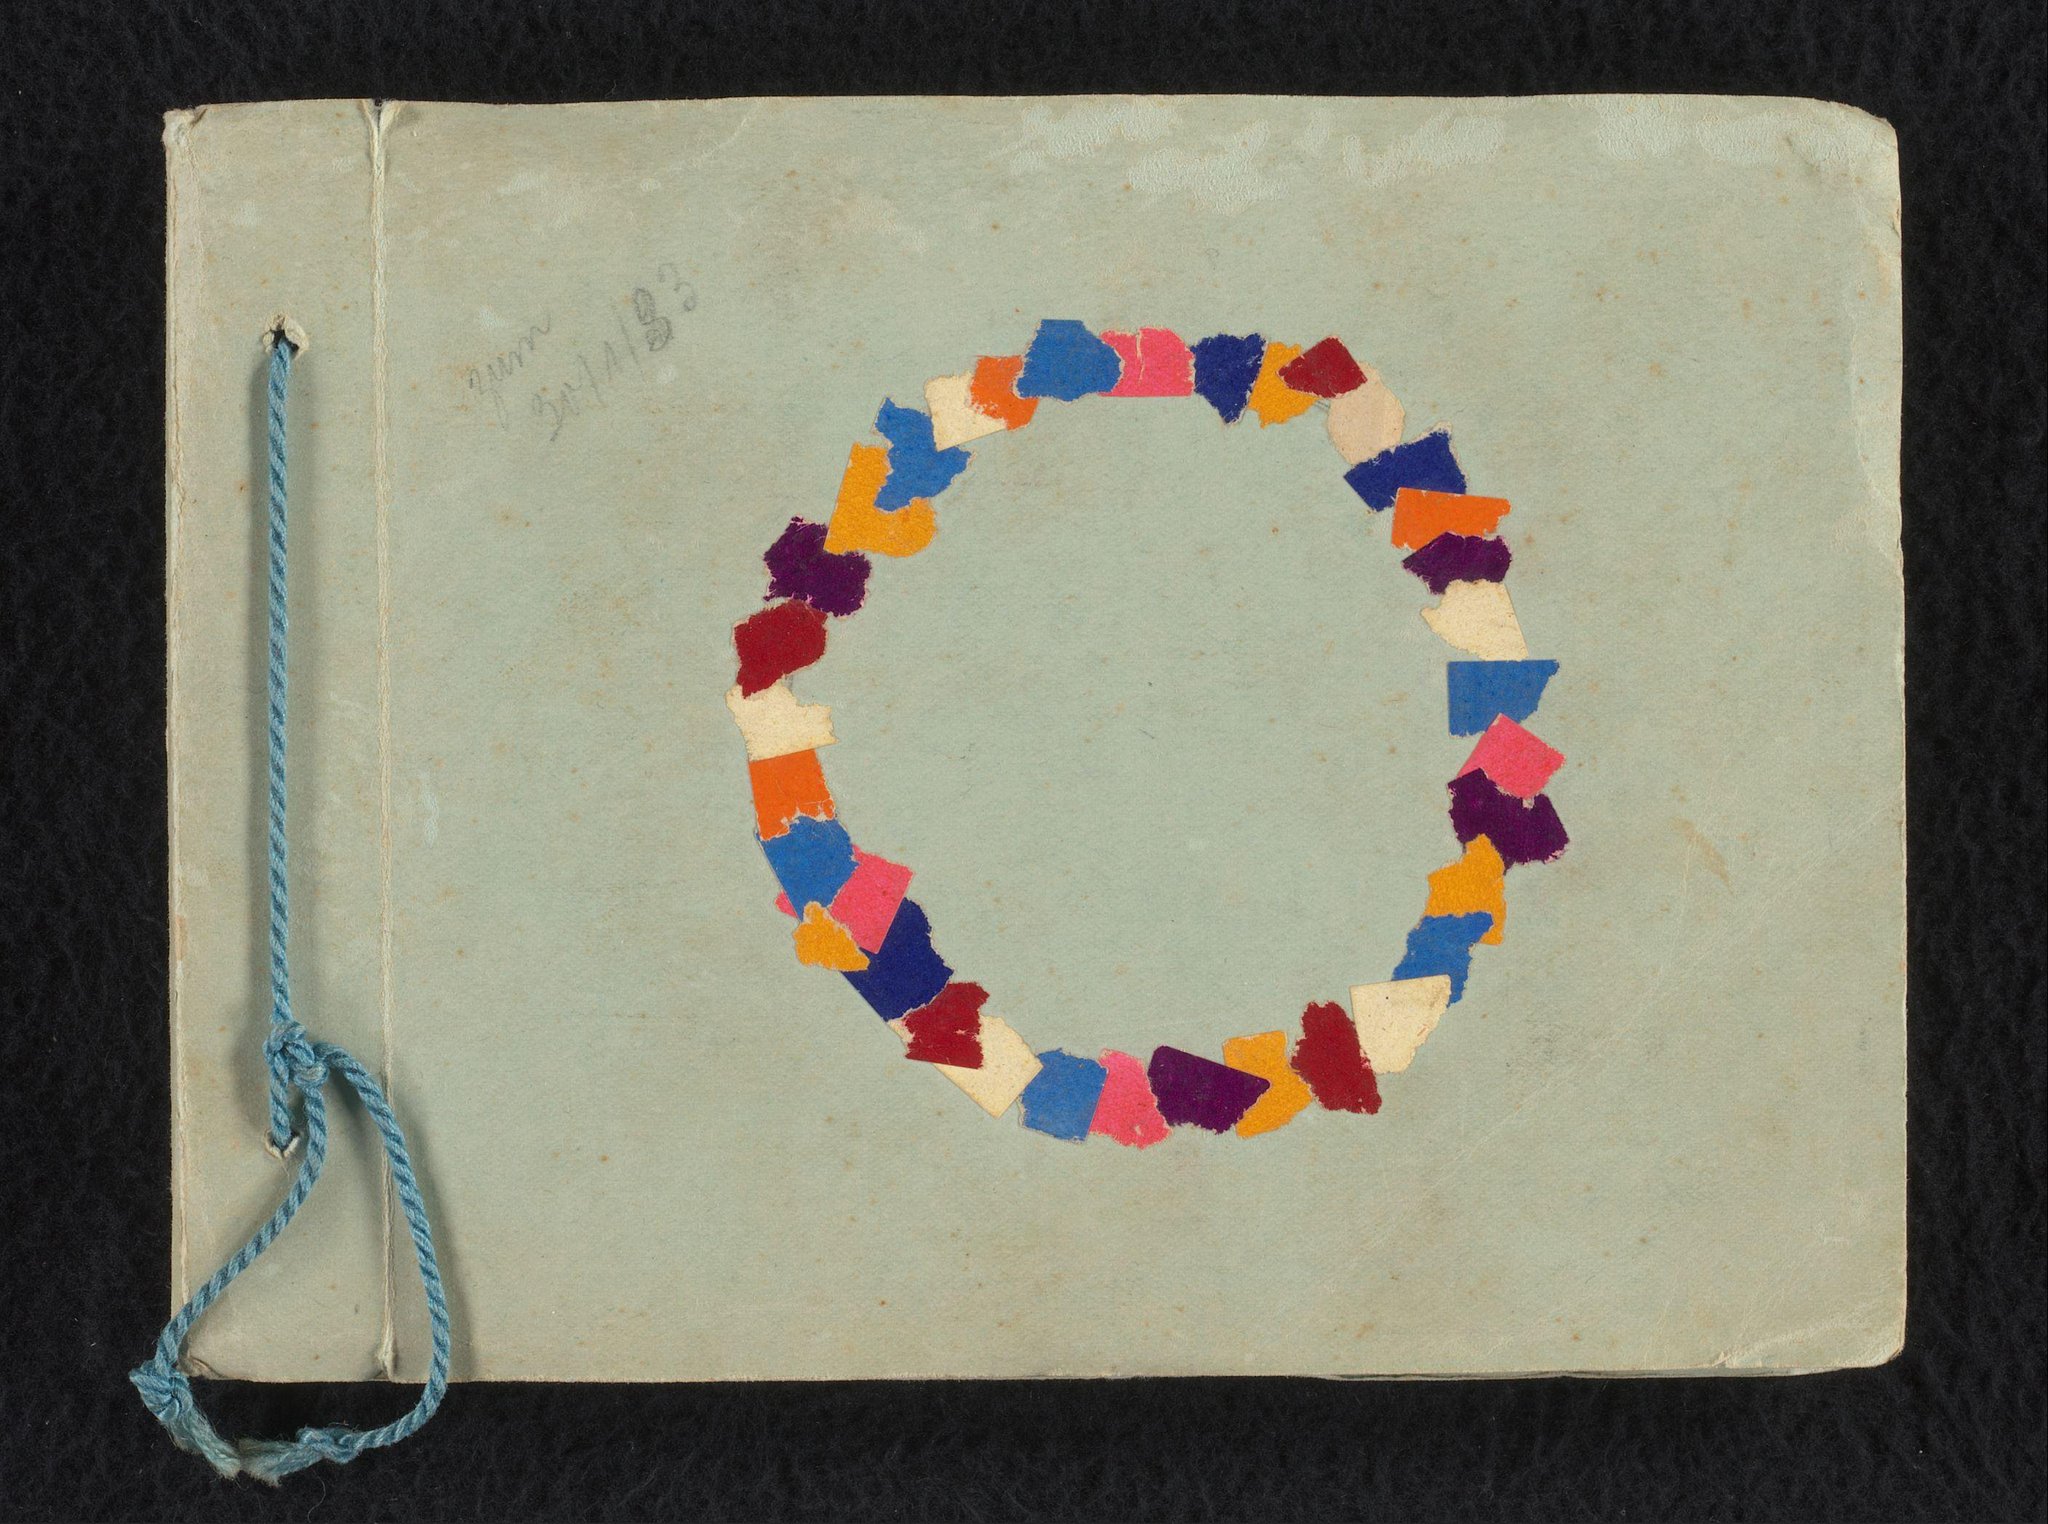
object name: slip in album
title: Fotoalbum met foto's van Isabel Wachenheimer met haar ouders Eugen Wachenheimer en Else Wachenheimer-Moos en haar grootouders Meir Wachenheimer en Mathilde Wachenheimer-Moos, 1932-1937, Stuttgart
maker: else wachenheimer-moos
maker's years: 1895-1944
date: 1932-1937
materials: cardboard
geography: stuttgart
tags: eugen wachenheimer, else wachenheimer-moos, leiden, isabel wachenheimer-elon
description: Dit object is onderdeel van de nalatenschap van Isabel Elon-Wachenheimer (1928-2010). Tot haar overlijden behoorde het samen met de andere objecten uit de nalatenschap tot haar privédomein van Isabel Wachenheimer. In die particuliere context zijn deze objecten tezamen en individueel aandenkens - aan de jeugd, ouders en familie van Isabel Wachenheimer vóór en tijdens de Shoah en aan haar leven na de Tweede Wereldoorlog. Isabel Wachenheimer, die van juni 1943 tot mei 1945 gevangen zat in Kamp Westerbork, Theresienstadt, Auschwitz, Lenzing a/d Oberdonau (een buitenkamp van Mauthausen), overleefde de Shoah. Haar ouders – Eugène Wachenheimer en Else Wachenheimer-Moos - werden op 14 oktober 1944 in Auschwitz-Birkenau vermoord.